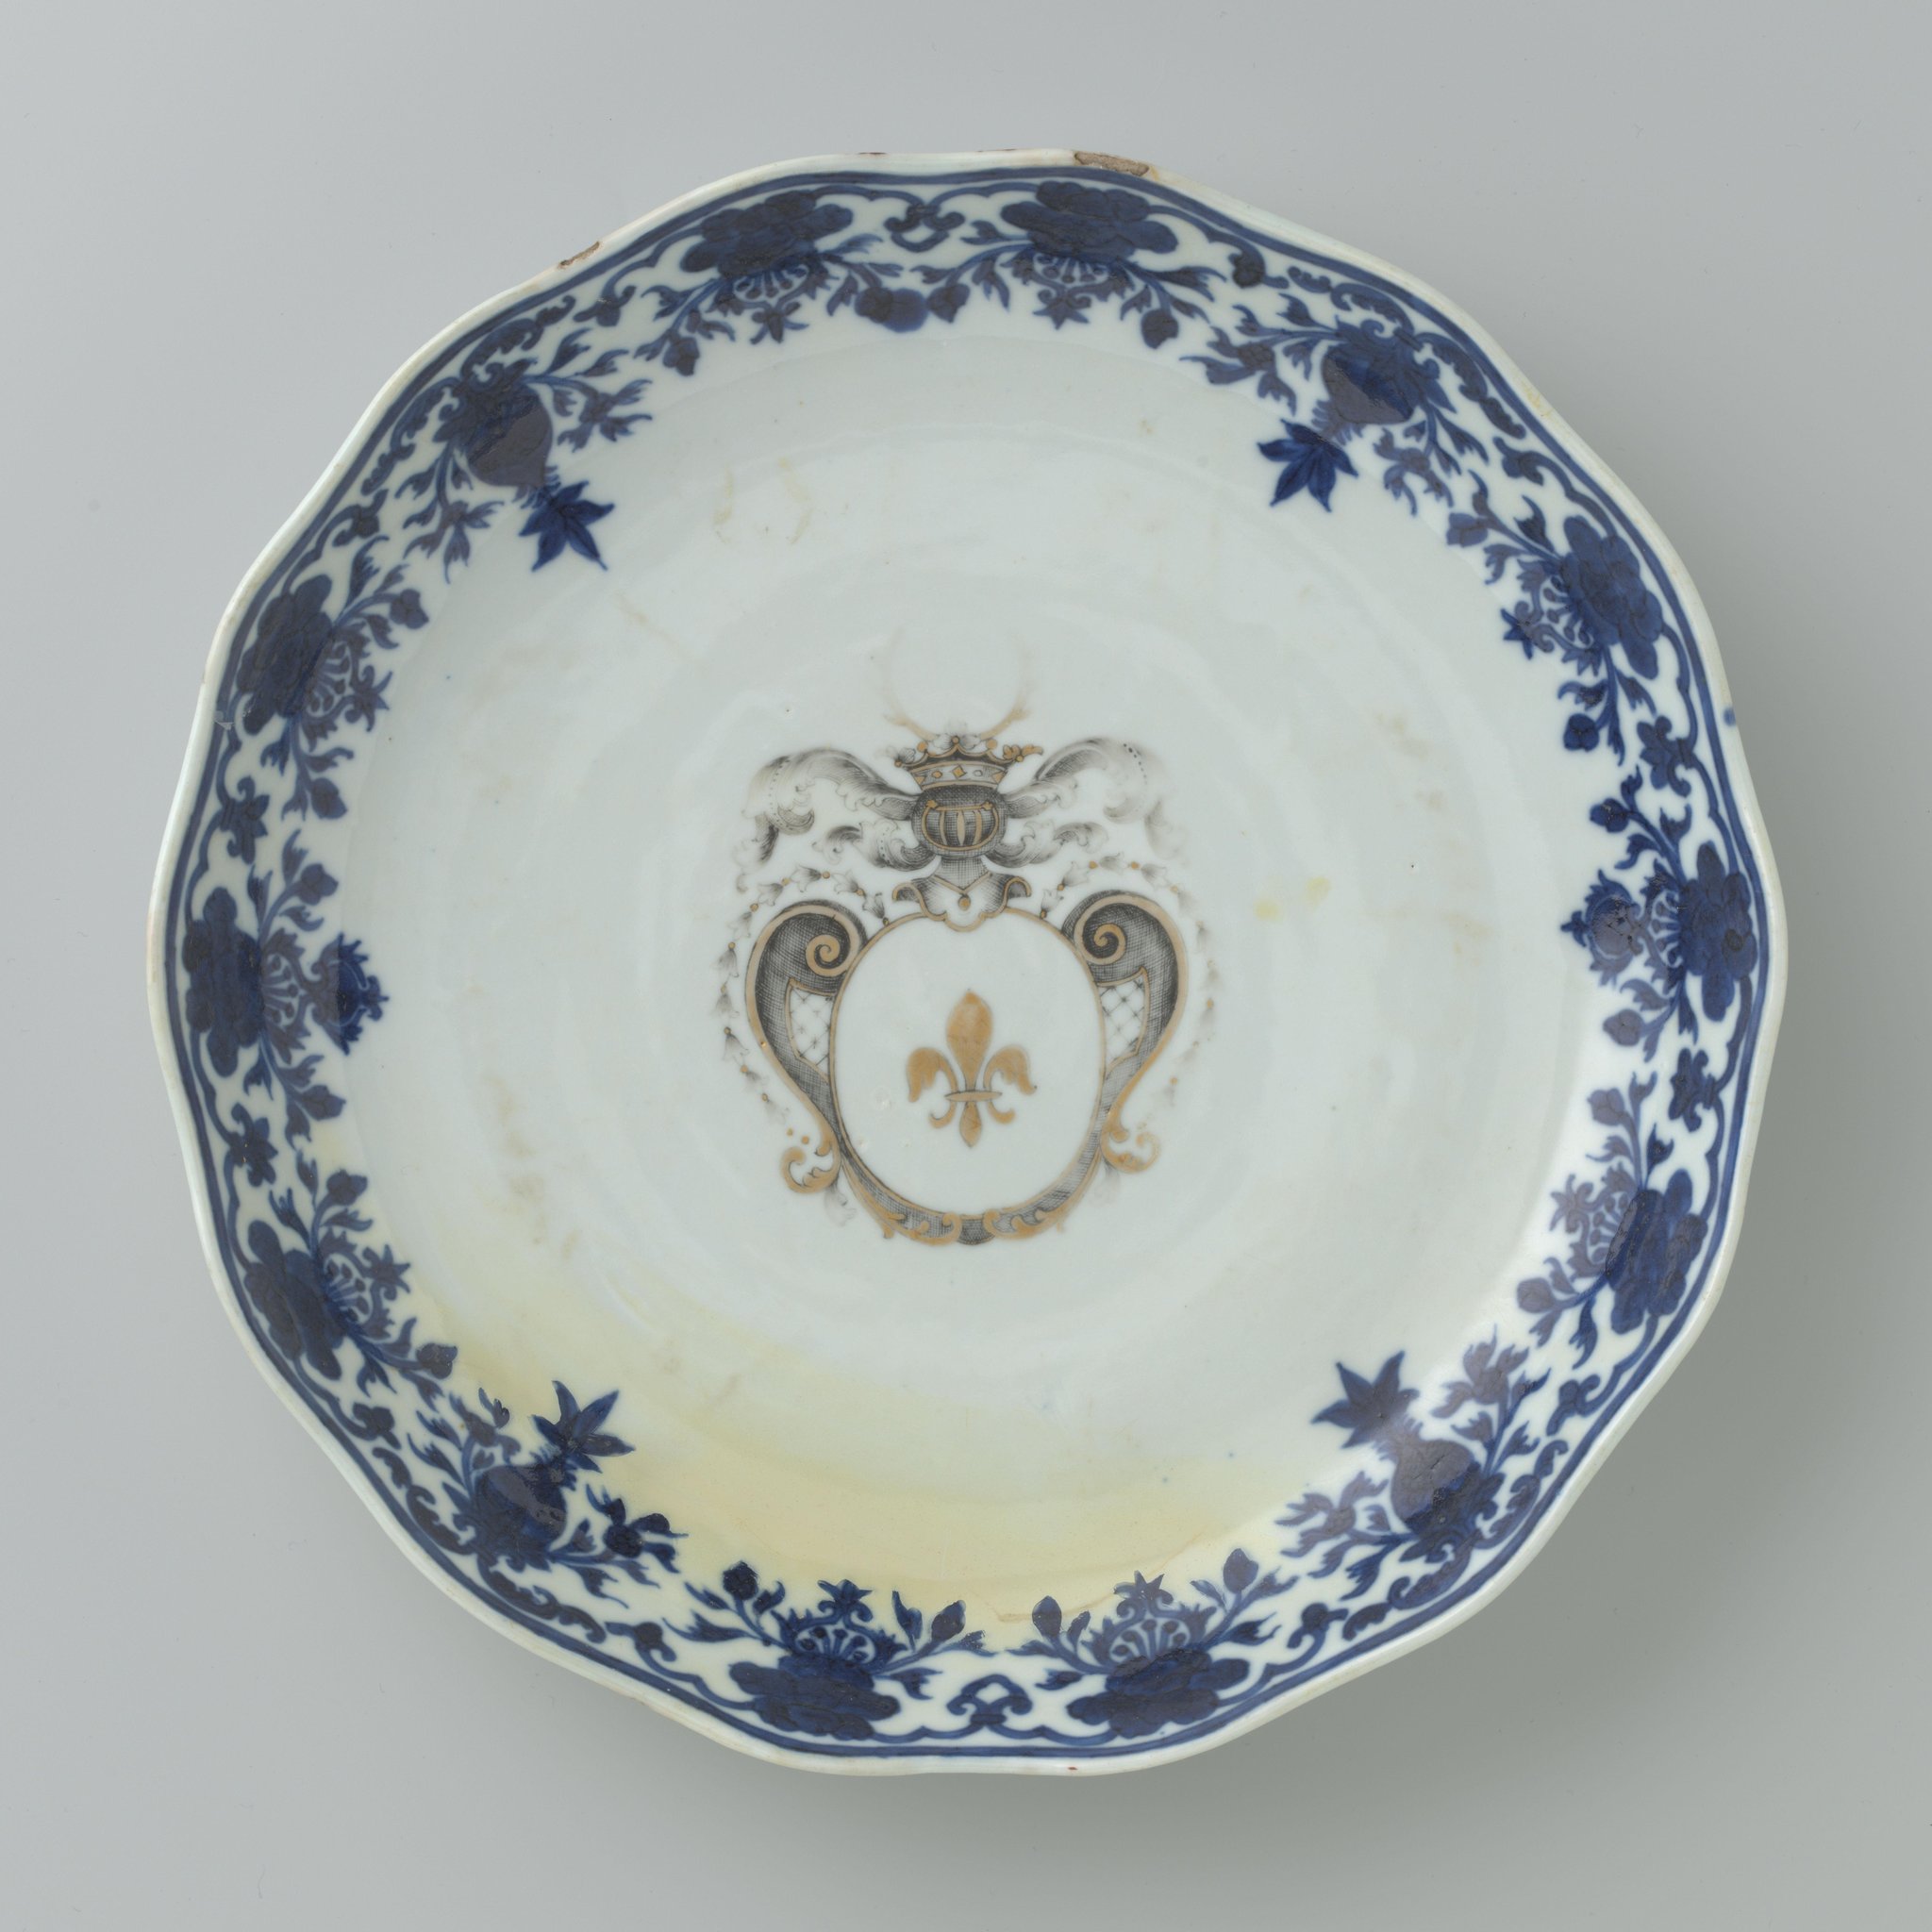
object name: soup plate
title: Diep bord met het wapen van de familie Swellengrebel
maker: Anonymous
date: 1740-1750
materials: cobalt, glaze, gold, paint, porcelain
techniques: firing, gilding, turning, vitrification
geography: china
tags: utrecht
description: Diep bord op een voetring en met een golvende rand. Beschilderd in onderglazuur blauw en met zwart en goud op het glazuur. Rond de rand een brede band met bandwerk en bloemranken in blauw met goud. In het centrum het wapen van de familie Swellengrebel in zwart en goud: Franse lelie op een ovaal schild en een gewei boven een kroon als helmteken. Wapenporselein in blauw-wit en emailkleuren.